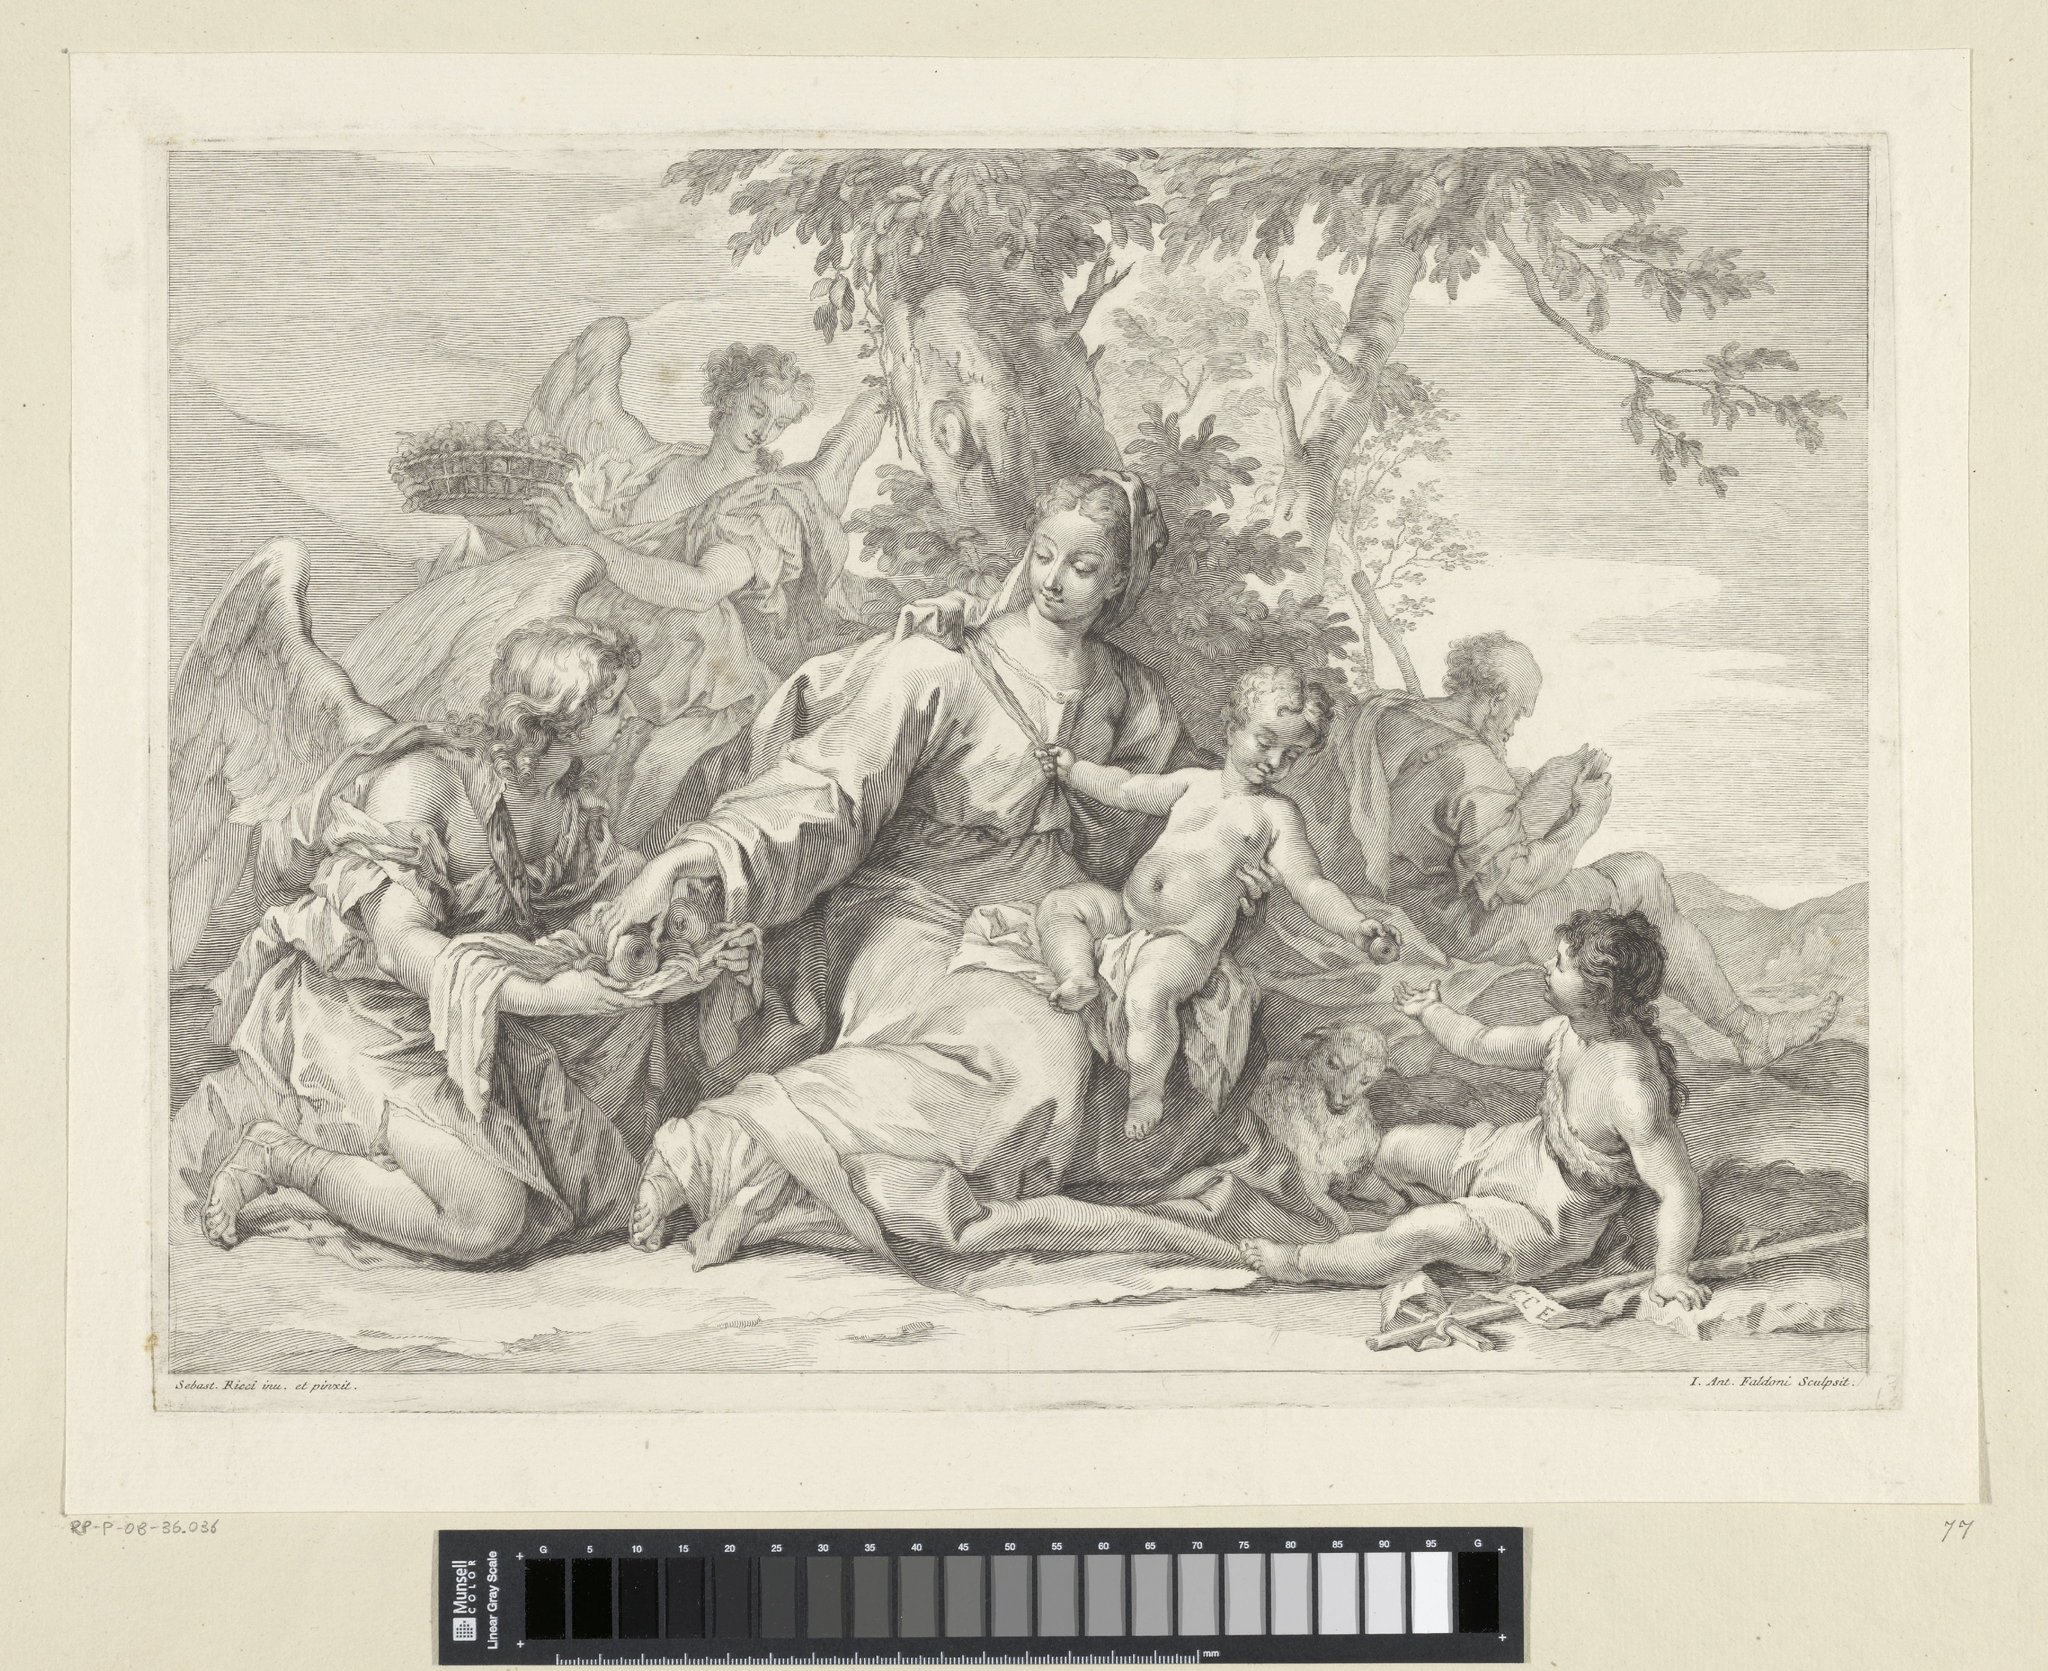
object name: print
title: Heilige Familie met de jonge Johannes de Doper en engelen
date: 1700-1760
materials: paper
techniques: engraving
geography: italy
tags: holy family, and derived representations, holy family with john the baptist (as child), angels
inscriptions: collector's mark: Lugt 240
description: Maria zit met het Christuskind op schoot onder een boom in een landschap. Links twee engelen die manden met vruchten aanbieden aan Maria. Christus geeft een appel aan de jonge Johannes de Doper. Op de achtergrond leest Jozef een boek.